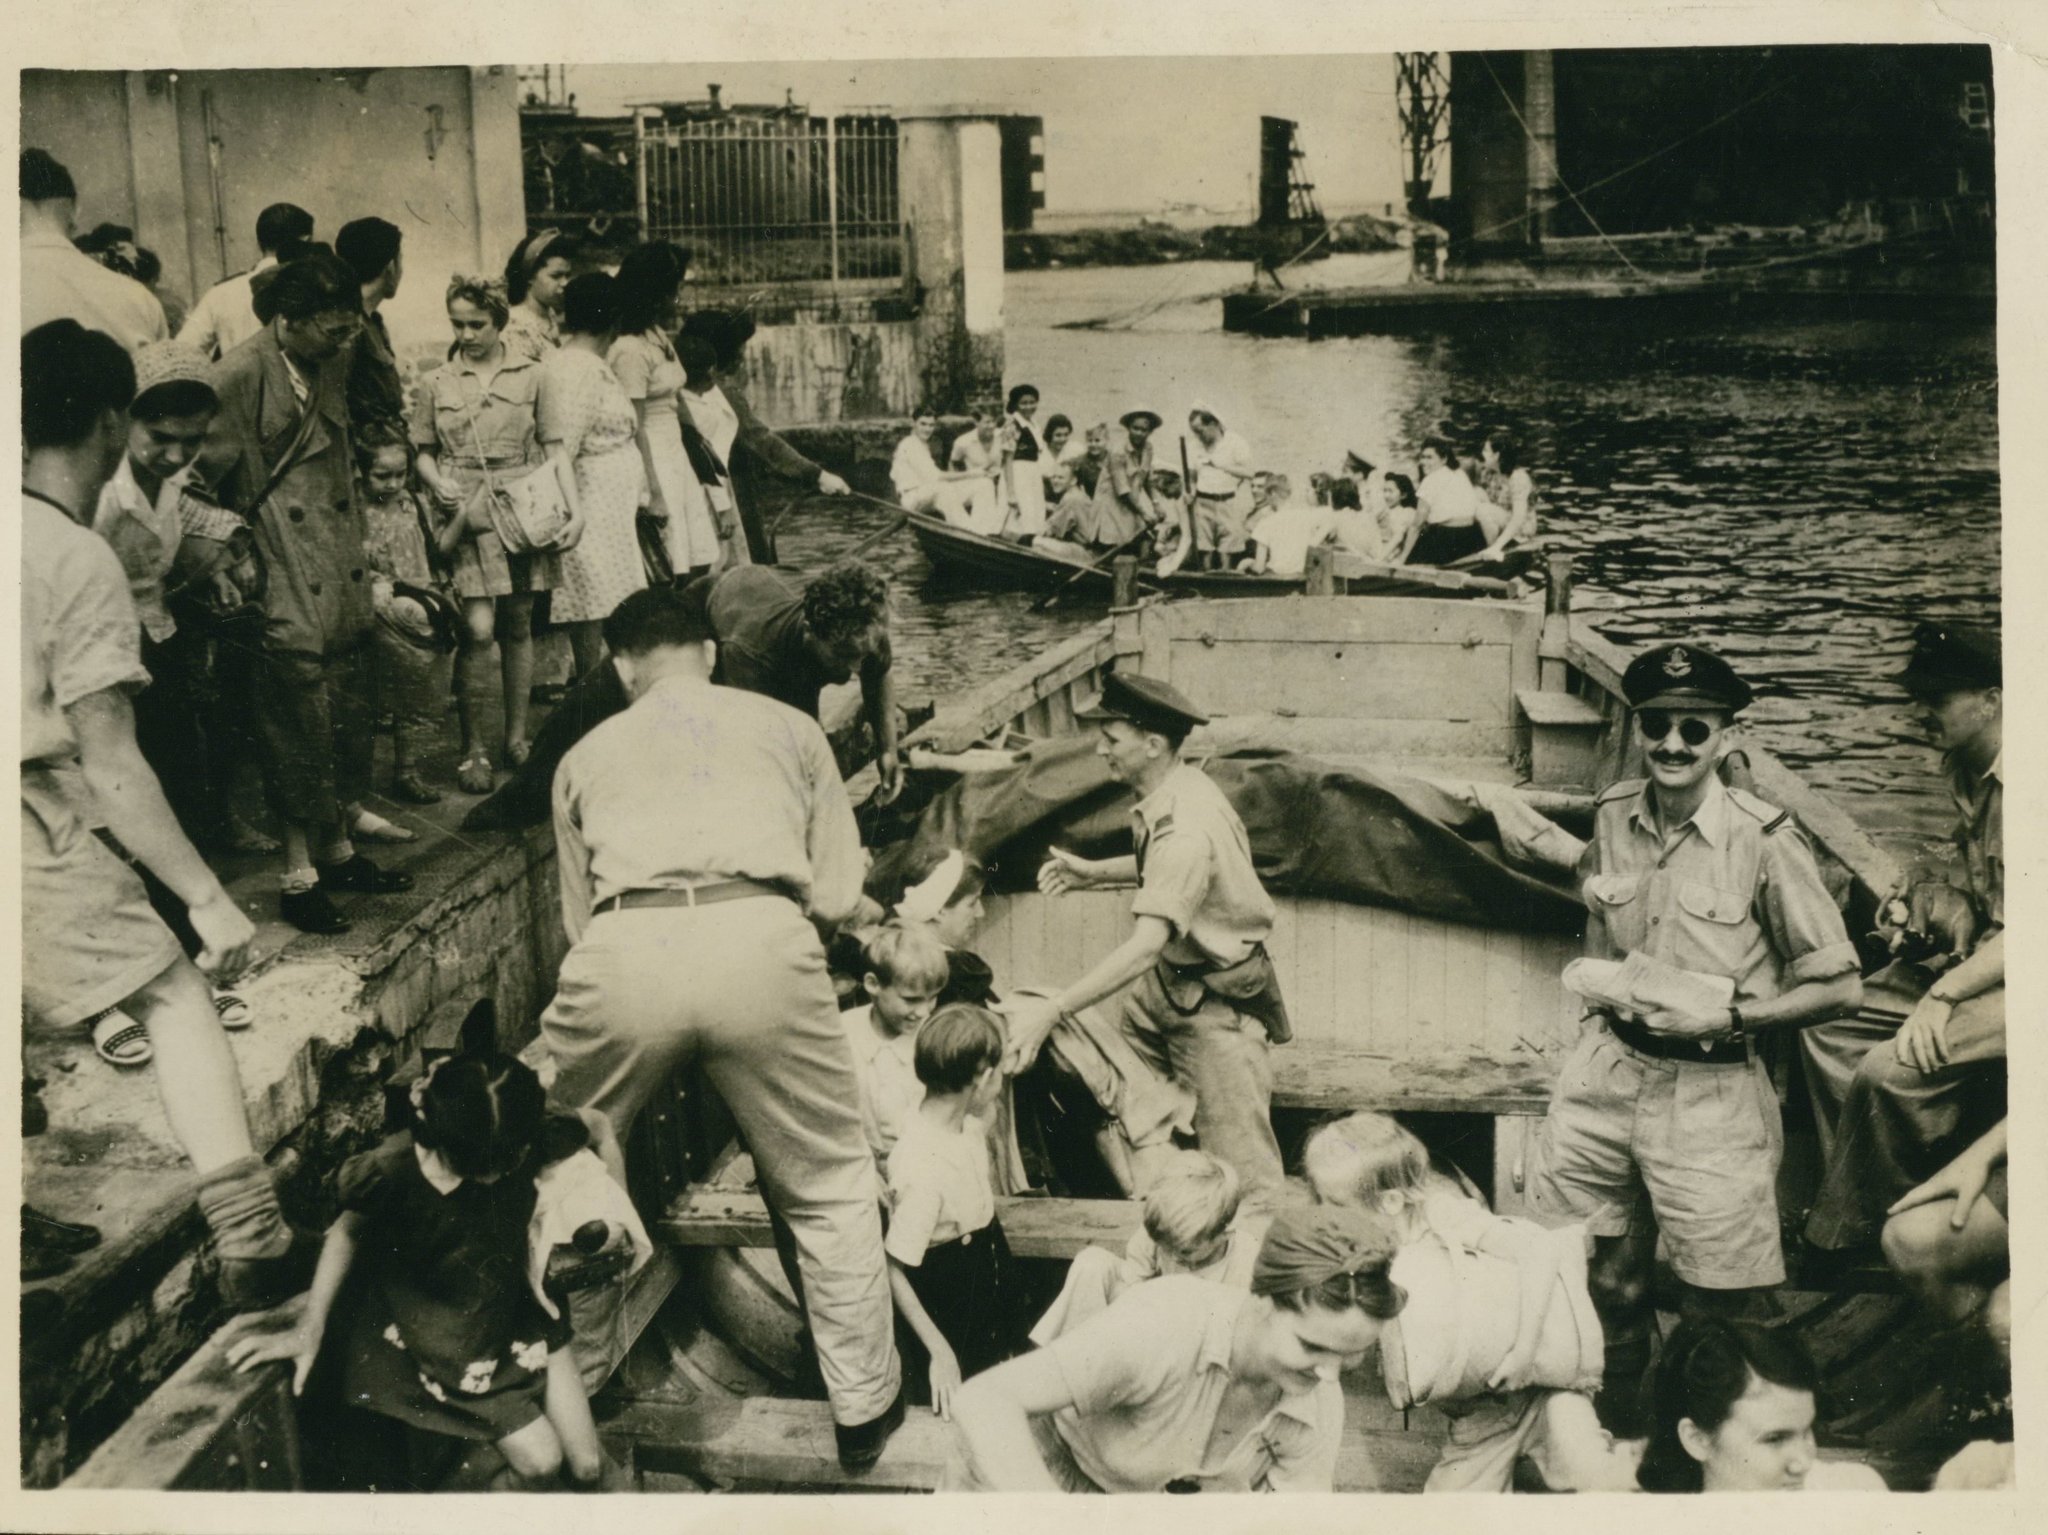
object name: documentary photograph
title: RAF Sunderland squadron evacueert Nederlandse geïnterneerden uit Batavia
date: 1945-1949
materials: photographic support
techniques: photography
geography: batavia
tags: batavia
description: Aan de kade in Batavia helpen een aantal RAF Sunderland leden een aantal vrouwen en kinderen in een sloep. Met de beroemde vliegboten worden de Nederlanders uiteindelijk naar Singapore gevlogen. Op de achtergrond een voor vertrek gereed liggende sloep.